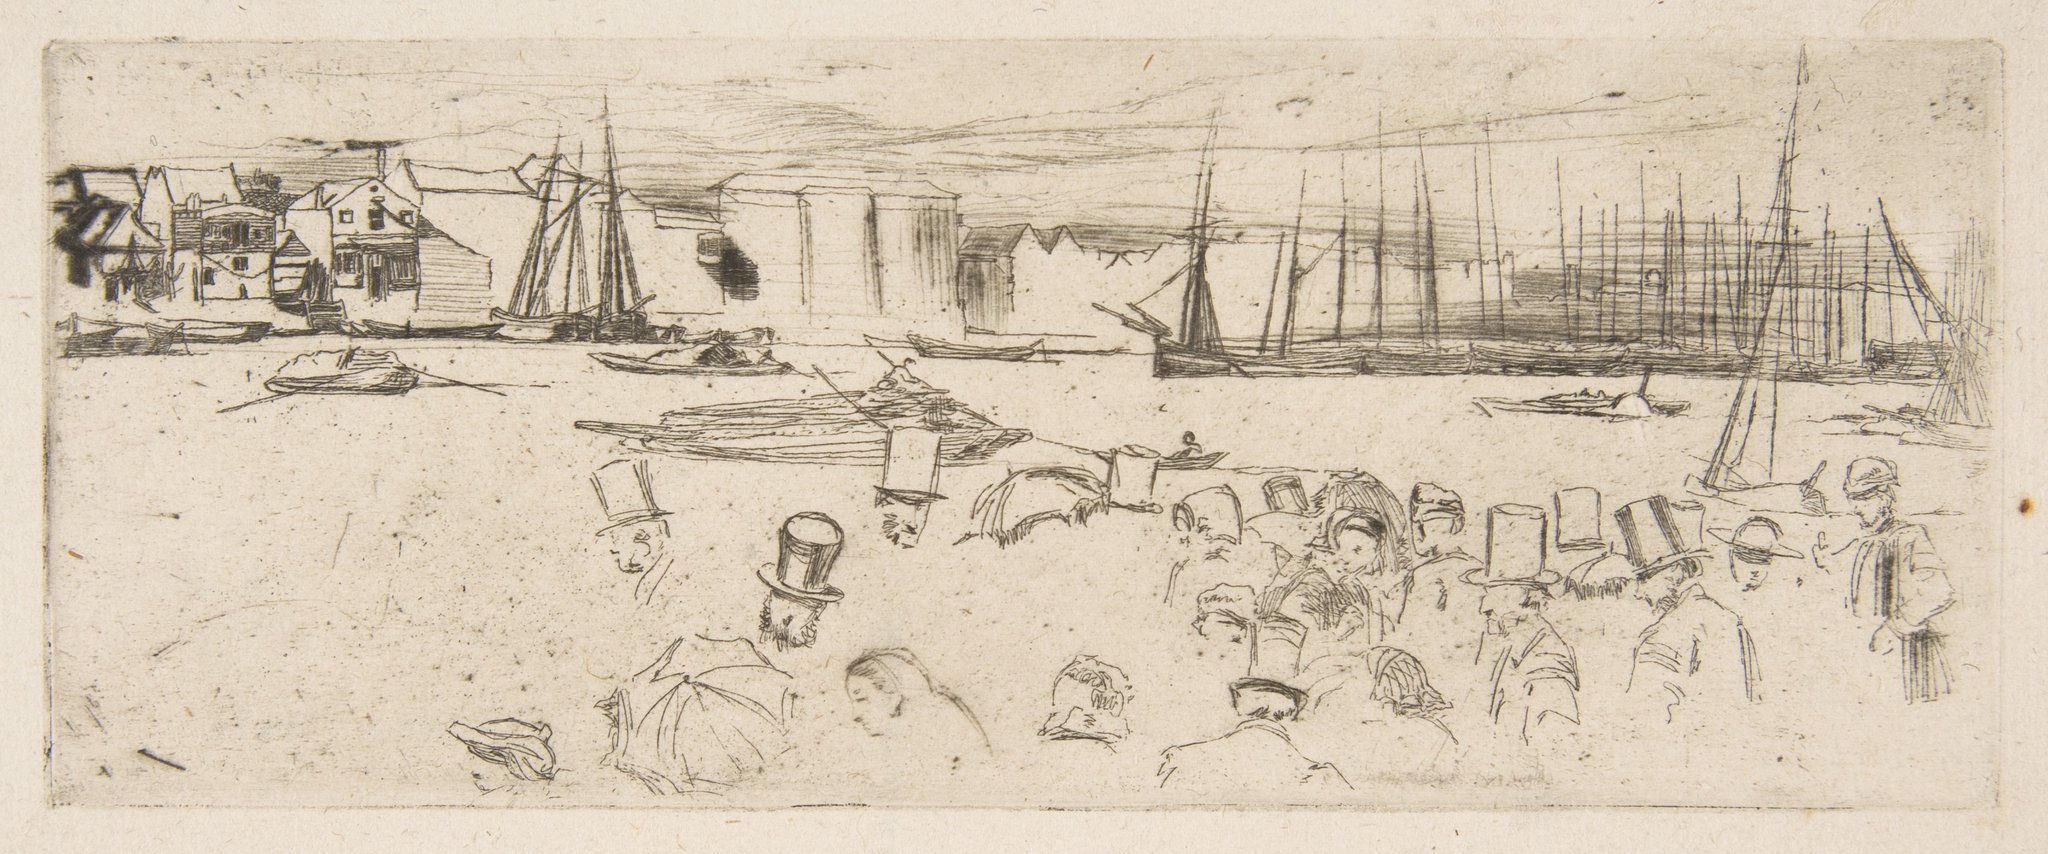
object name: print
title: The Penny Boat (Penny Passengers, Limehouse)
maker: james mcneill whistler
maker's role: artist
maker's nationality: american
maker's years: 1834-1903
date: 1860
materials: ink, paper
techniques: drypoint, etching, printing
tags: houses,men,boats